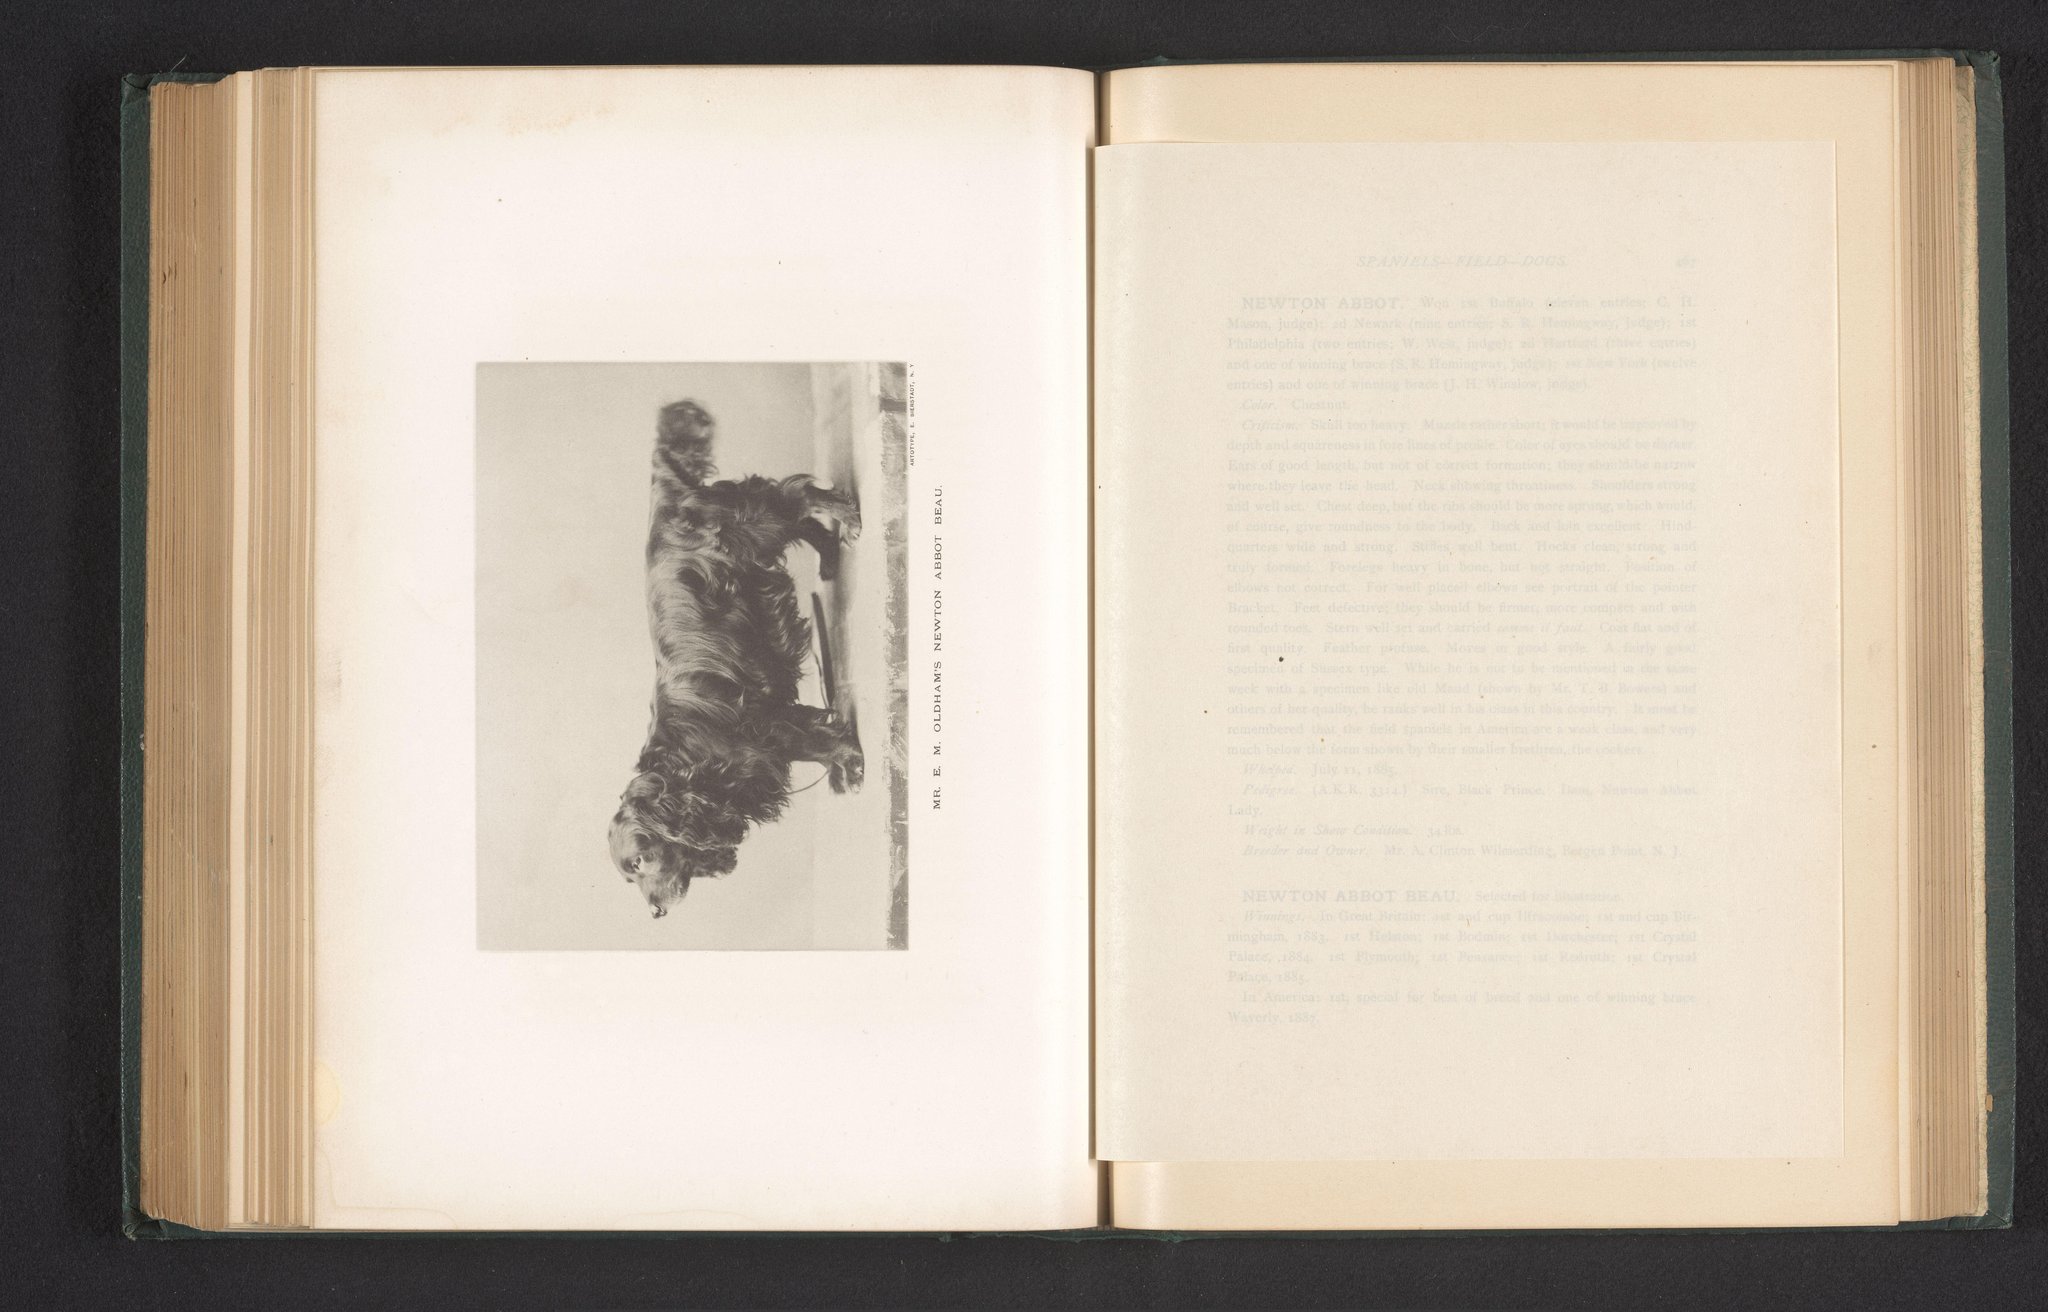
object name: page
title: Mr. E. M. Oldham's Newton Abbot Beau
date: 1883-1888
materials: paper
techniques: photograph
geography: new york city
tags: dog (with name of kind)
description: Prent tegenover pagina 467, achter semi-transparante omslag.